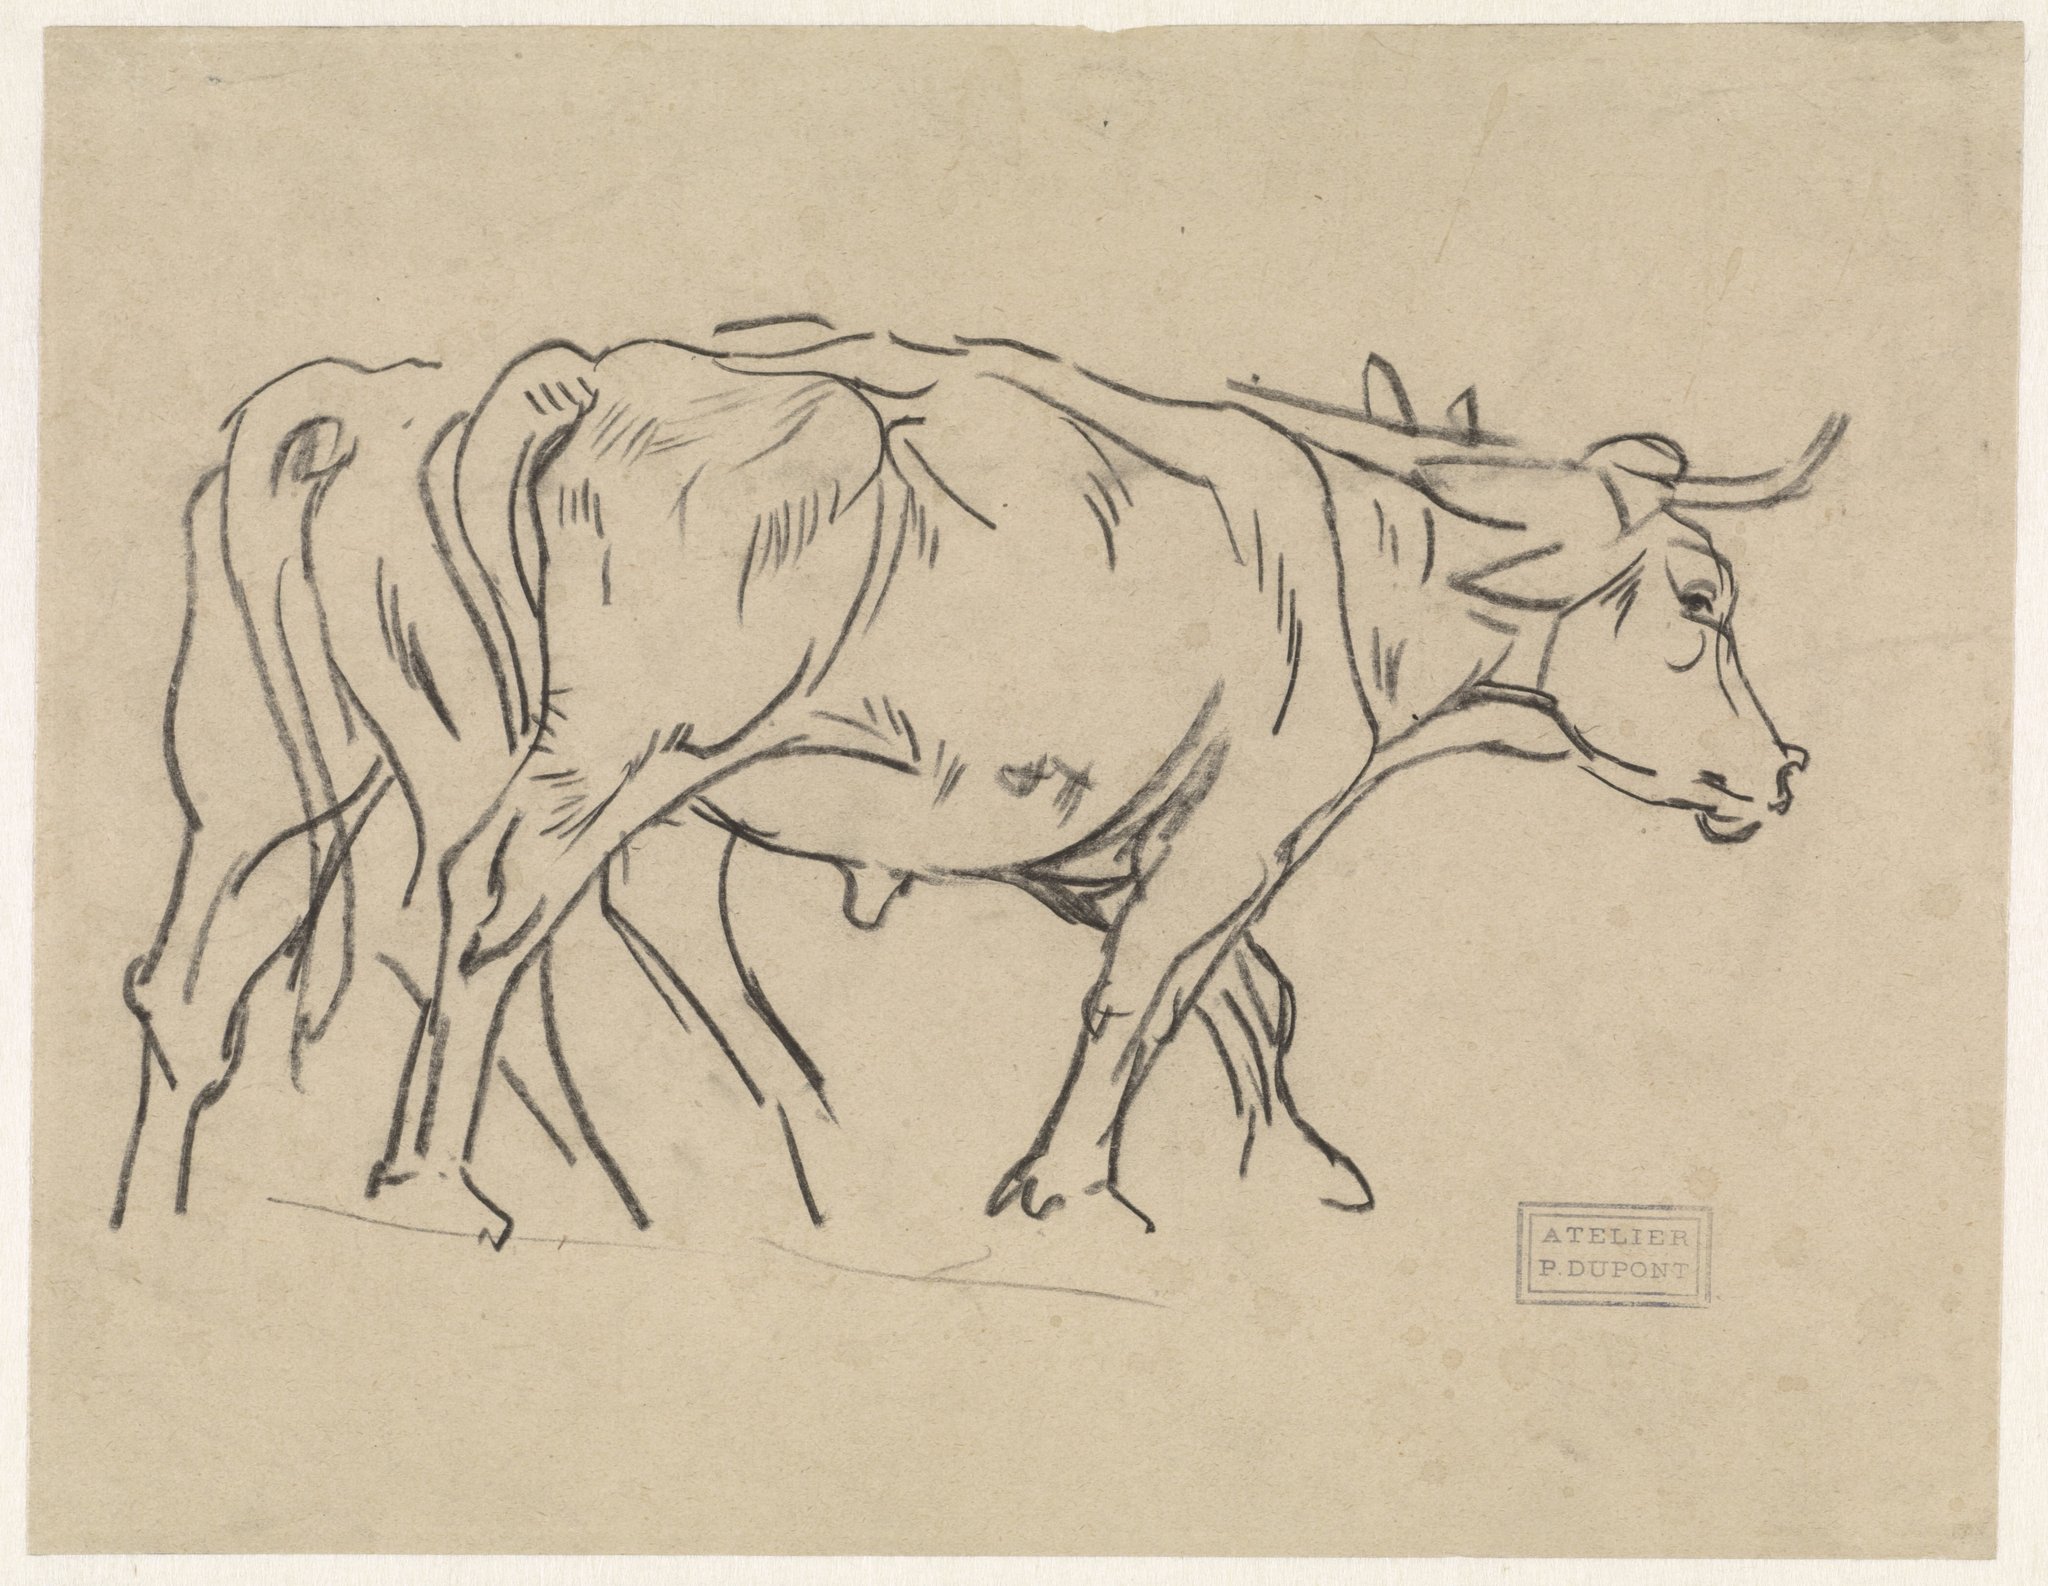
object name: drawing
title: Twee trekossen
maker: pieter dupont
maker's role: draughtsman, print maker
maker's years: 1870-1911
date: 1880-1911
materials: chalk, paper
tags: ox